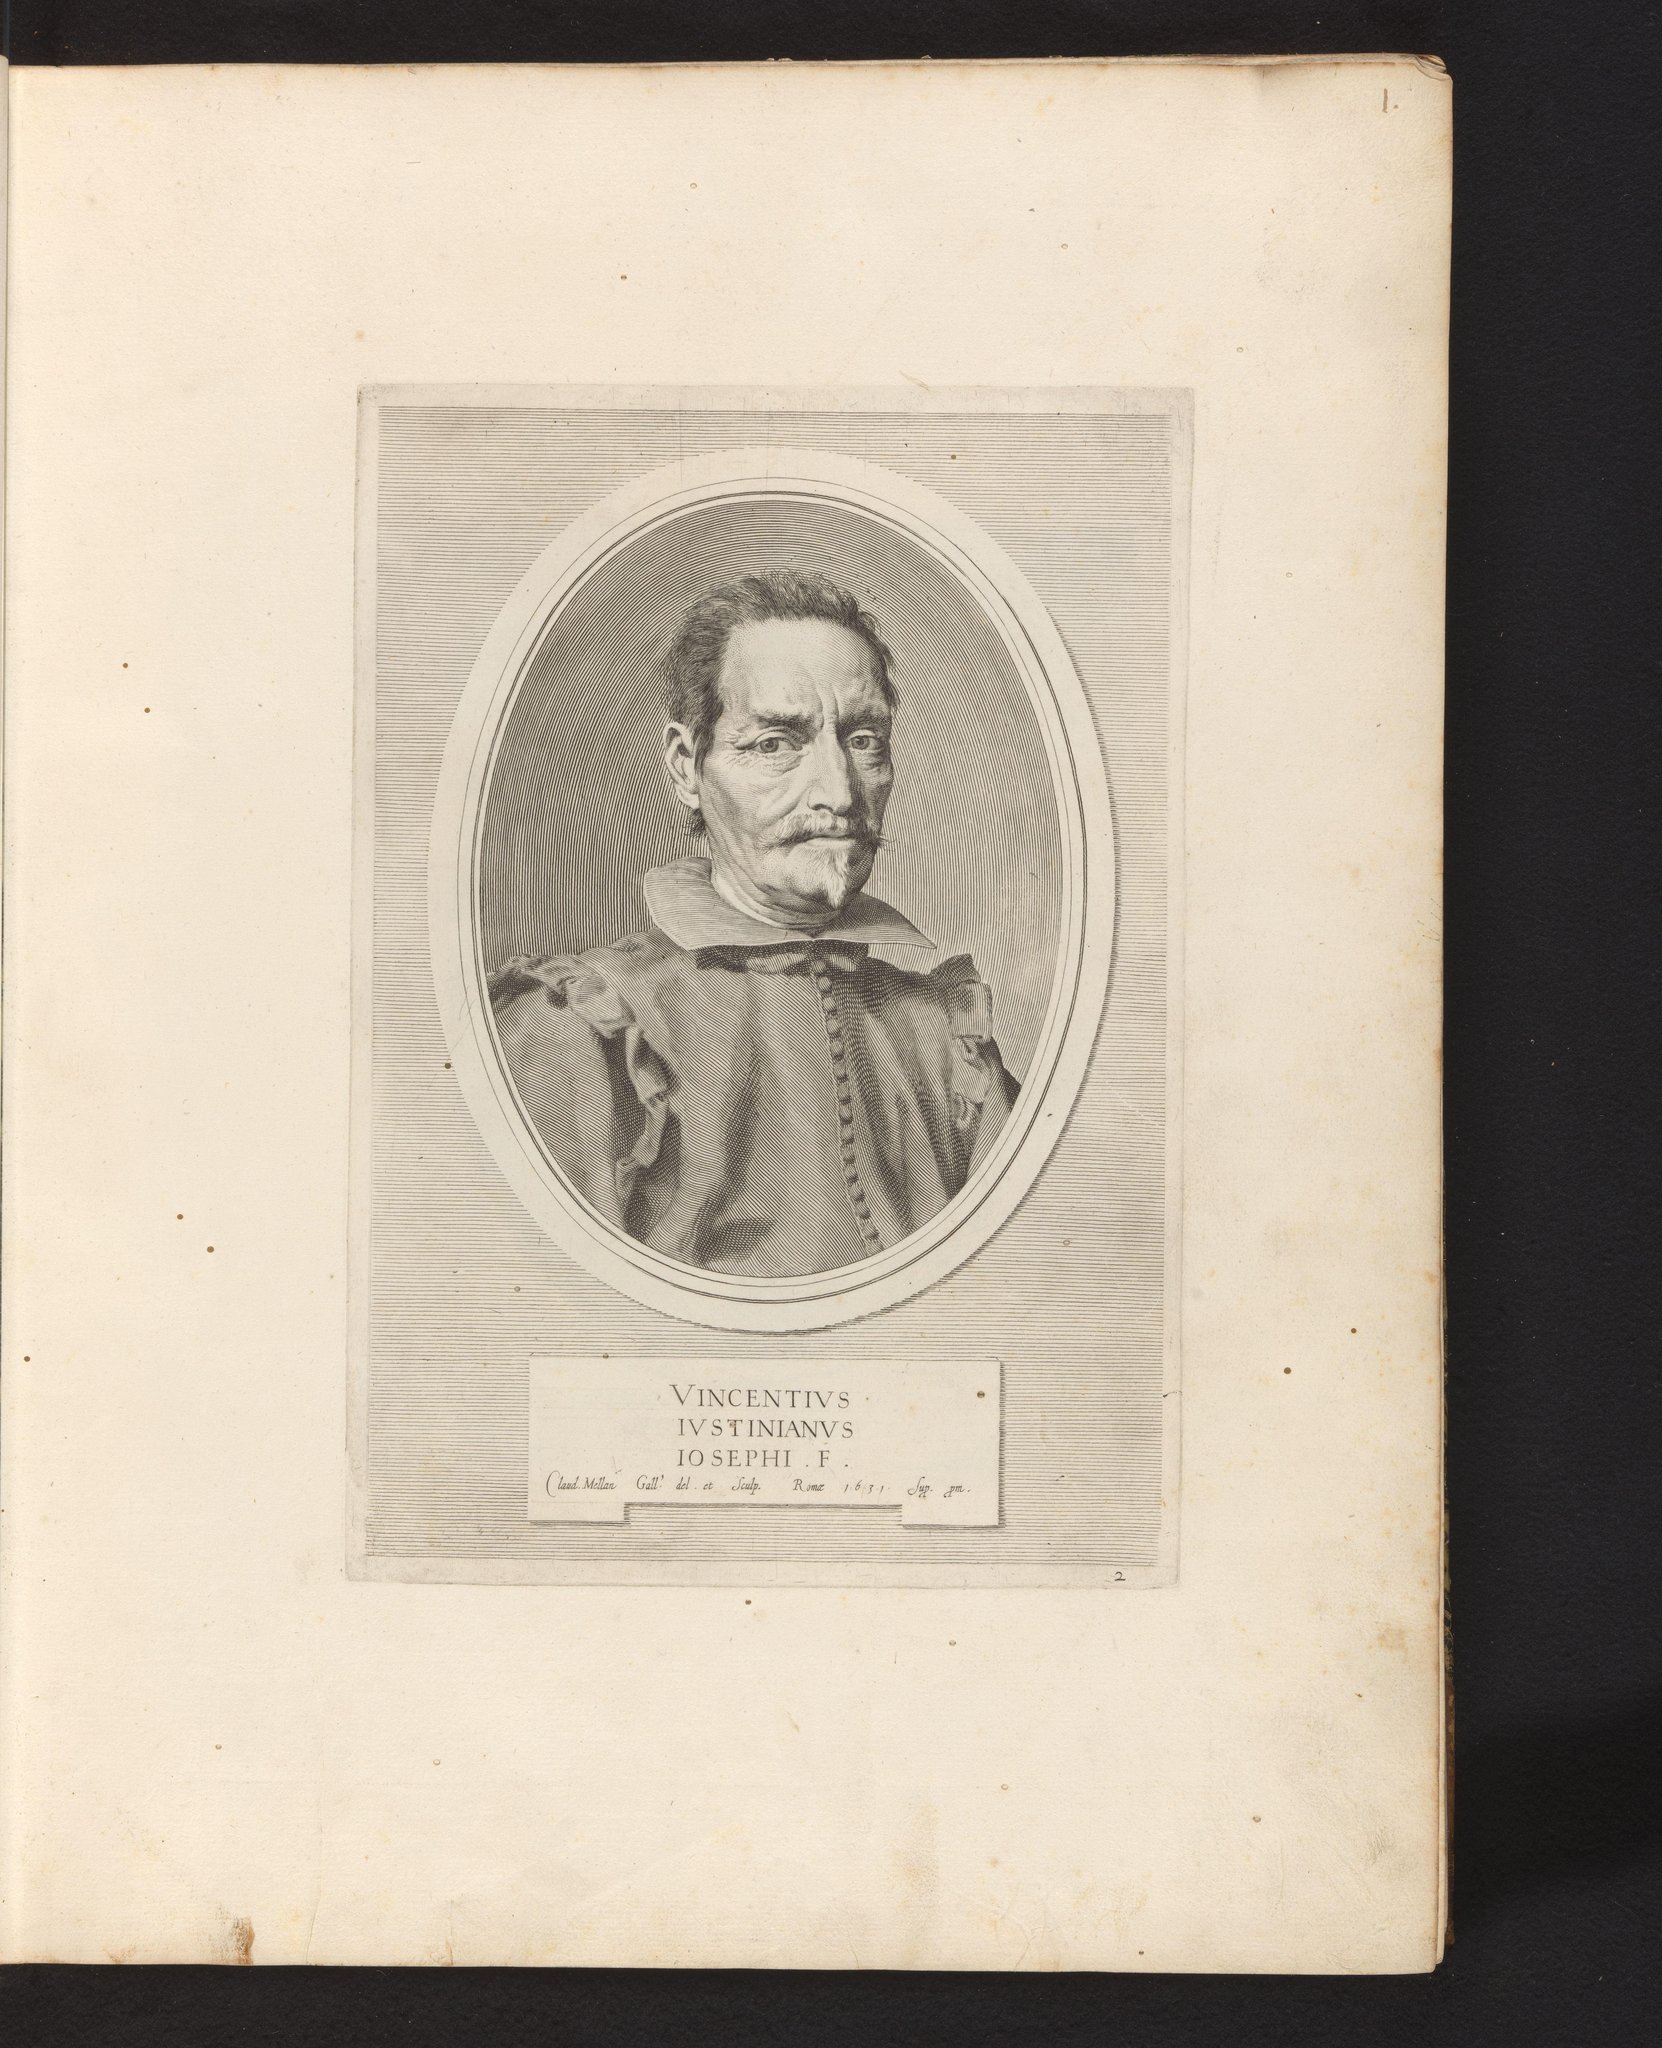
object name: print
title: Portret van Vincenzo Giustiniani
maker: claude mellan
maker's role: draughtsman, print maker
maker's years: 1598-1688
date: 1631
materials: paper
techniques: engraving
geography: rome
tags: rome, vincenzo giustiniani (1564-1637)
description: Portret van kunstverzamelaar Vincenzo Giustiniani. Prent maakt deel uit van een album.